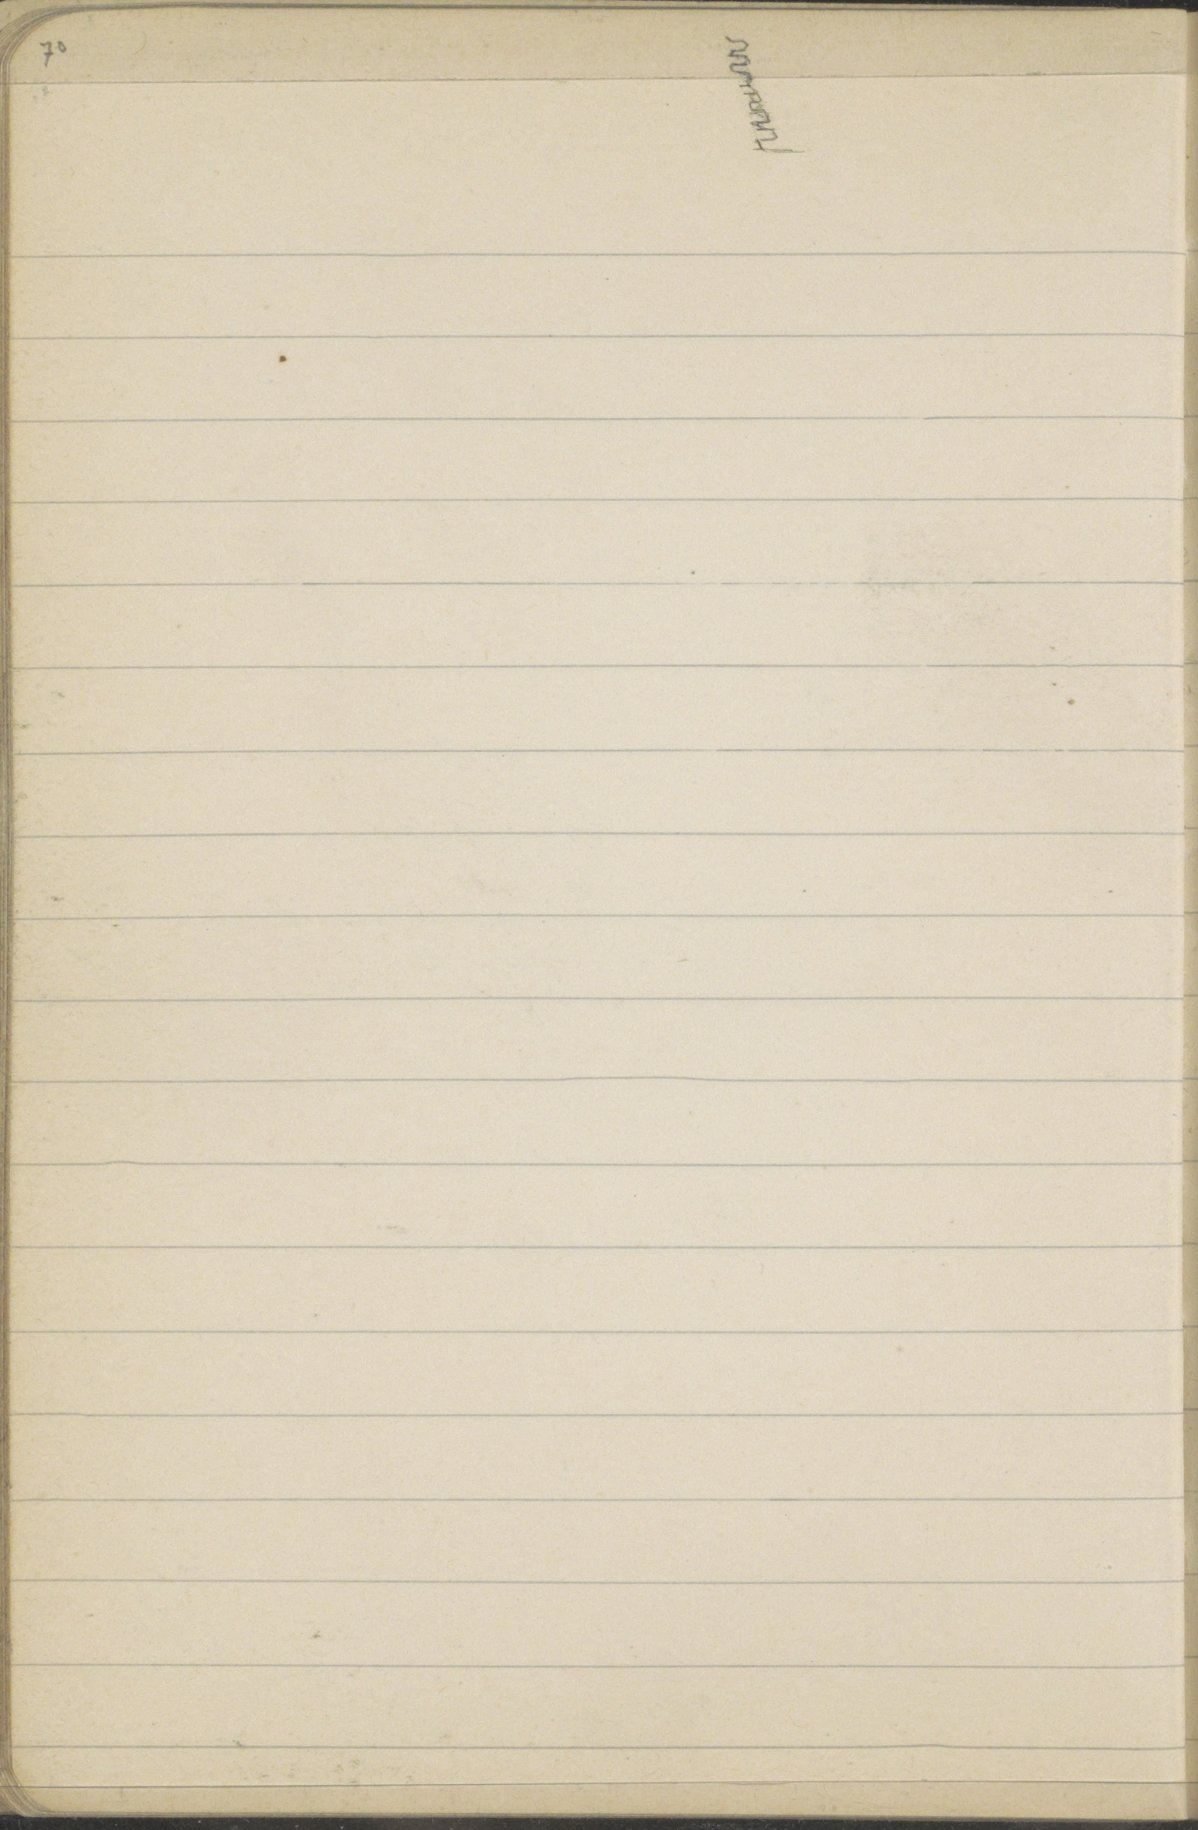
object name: sketchbook leaf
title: Kantelen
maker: marius bauer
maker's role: draughtsman, print maker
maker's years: 1867-1932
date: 1902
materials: pencil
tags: battlement, crenellation ~ fortified city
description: Pagina 70 uit een schetsboek met 50 bladen.